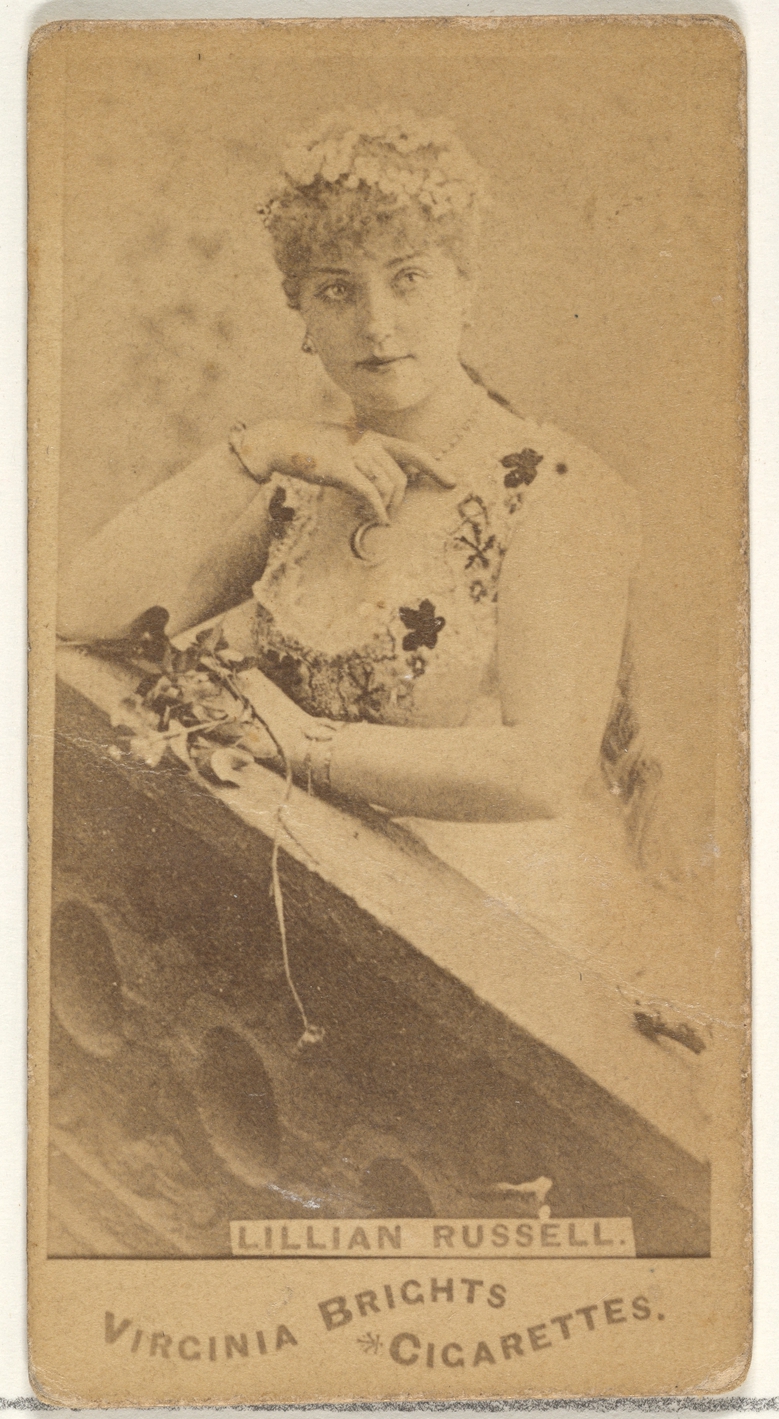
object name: photograph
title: Lillian Russell, from the Actors and Actresses series (N45, Type 1) for Virginia Brights Cigarettes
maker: allen & ginter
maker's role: publisher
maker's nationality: american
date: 1888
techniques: albumen silver print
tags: portraits,women,actresses